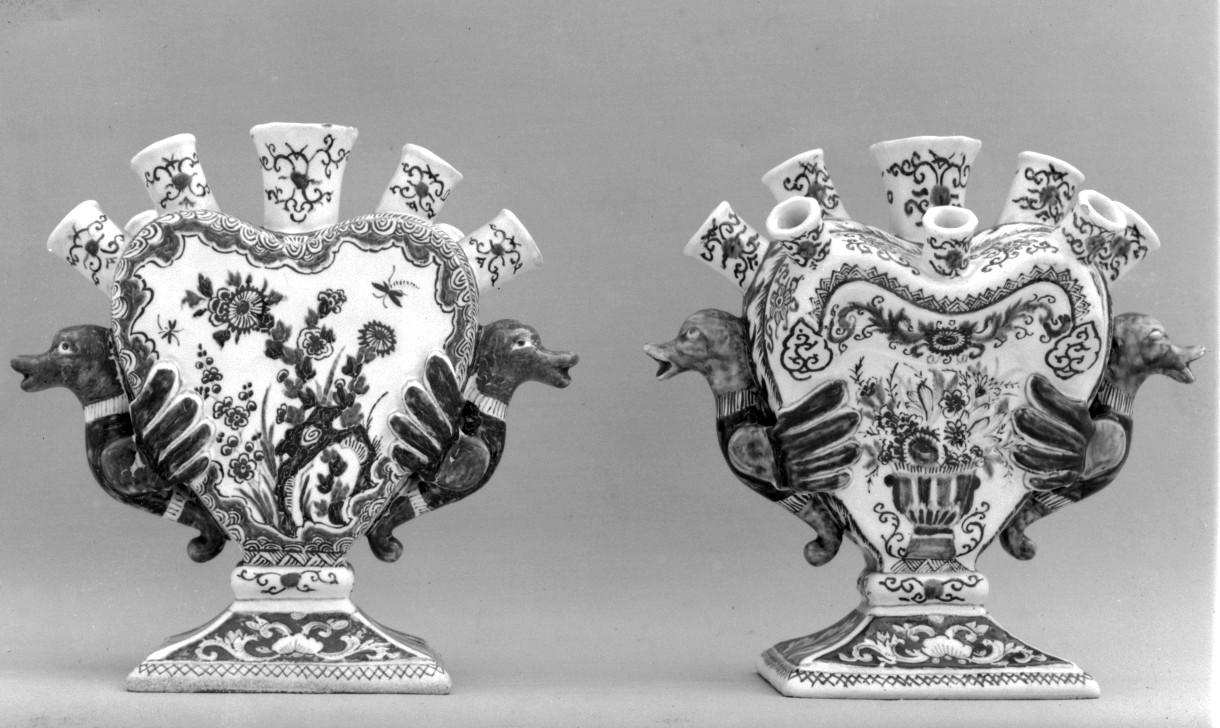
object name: nozzled vase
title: Pair of nozzled vases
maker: samson and company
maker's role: maker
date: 1801-1900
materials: earthenware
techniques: enamel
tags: birds,flowers